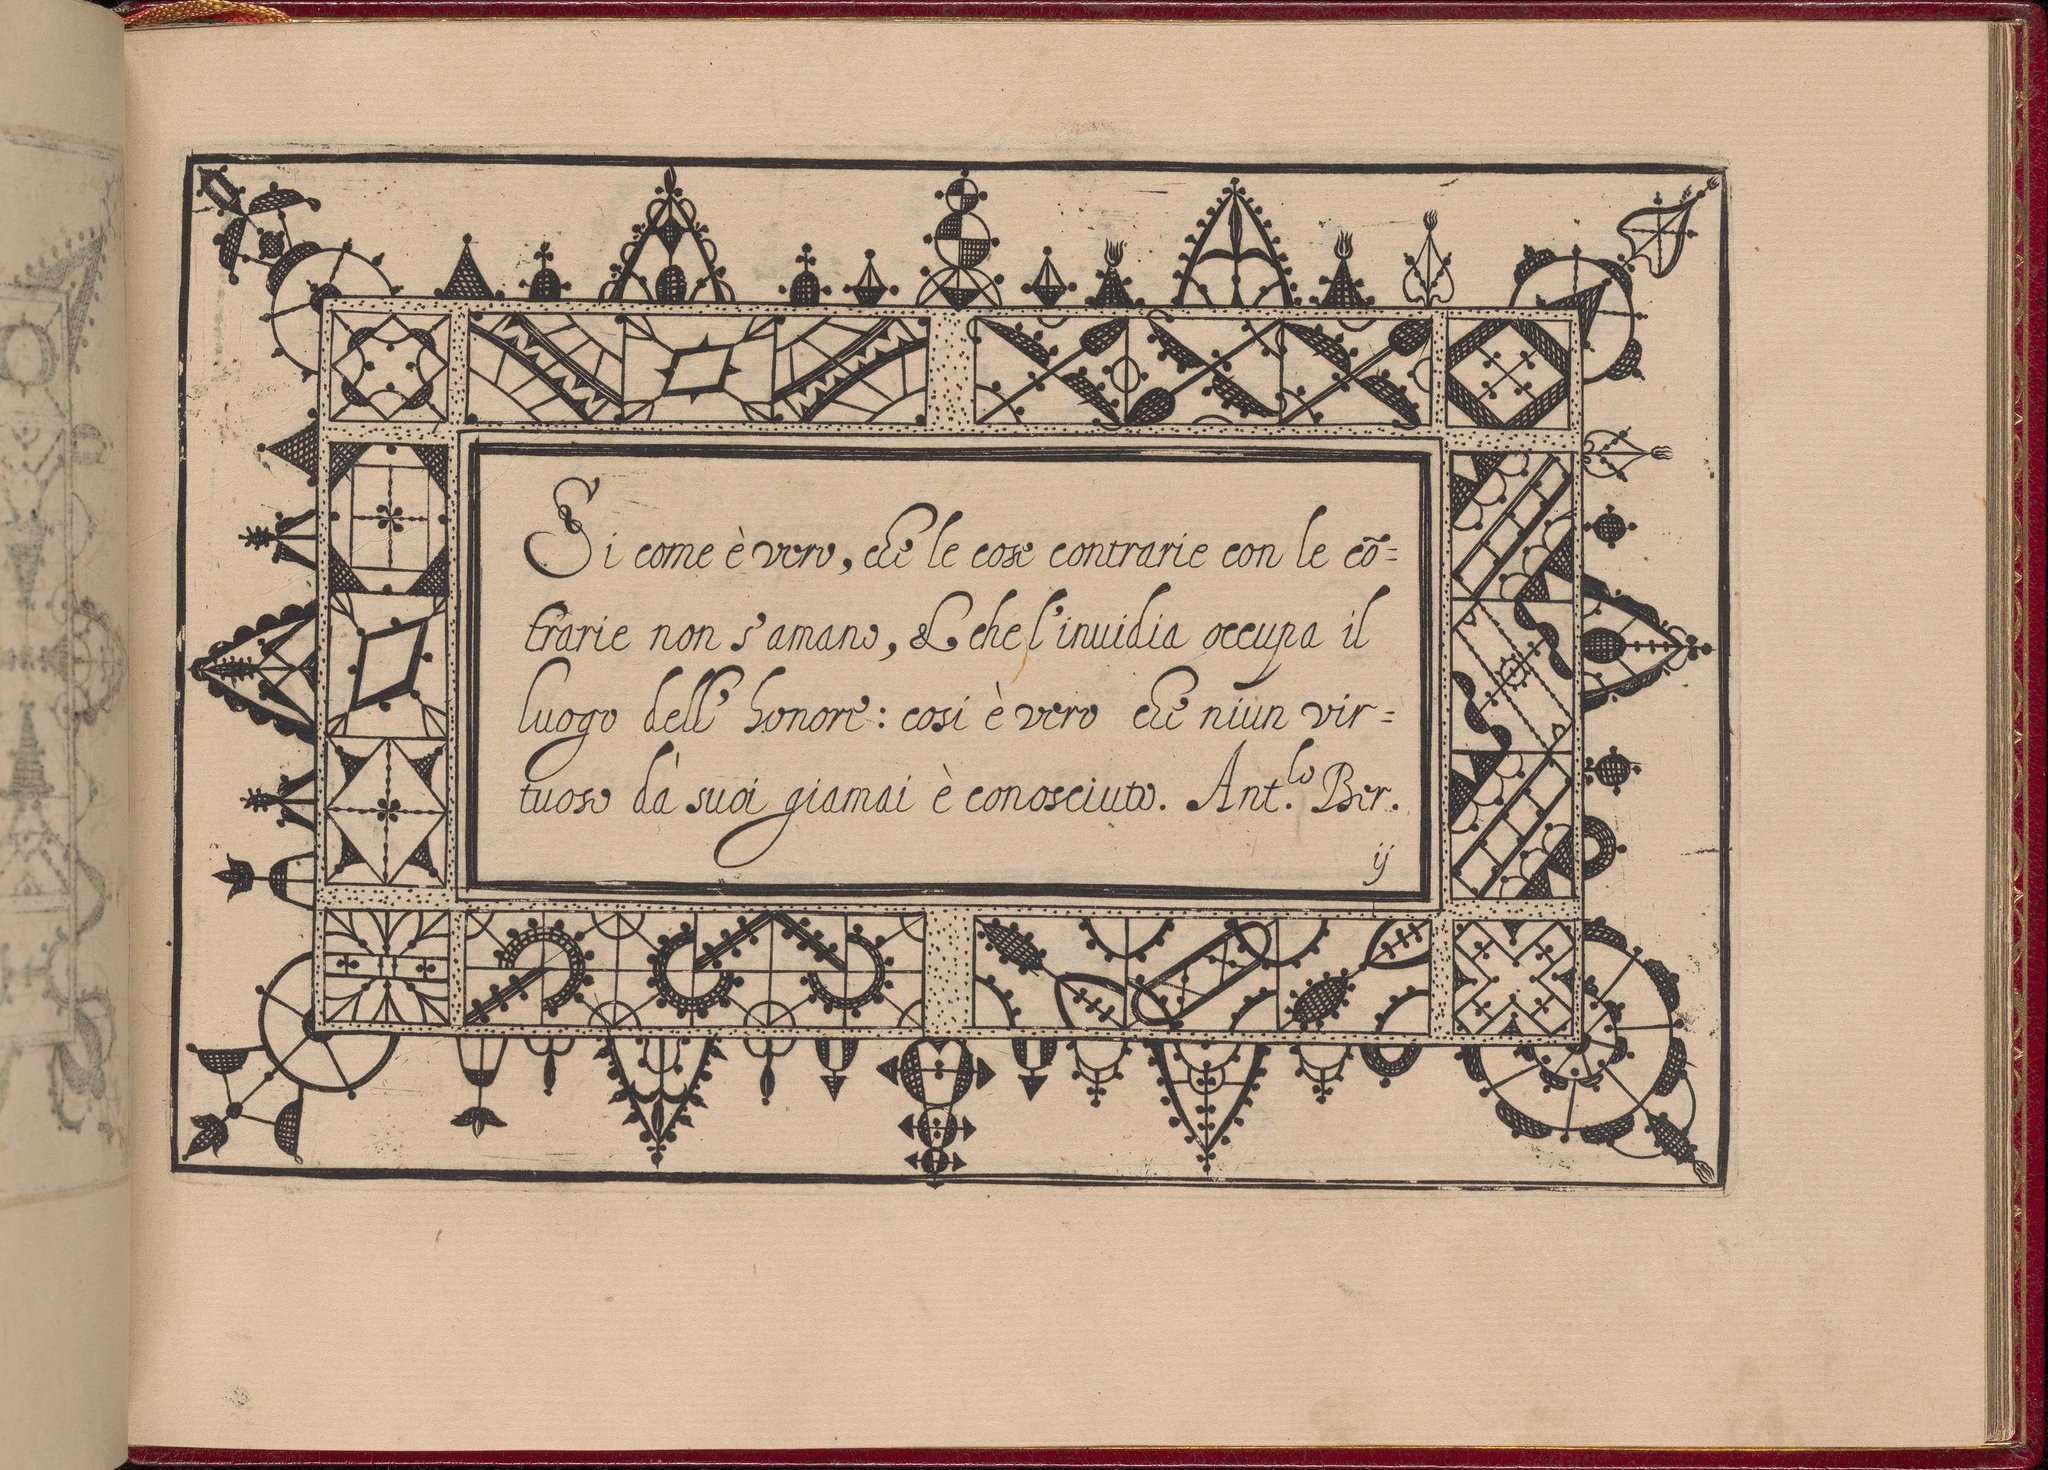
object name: book print ornament architecture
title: Ghirlanda: Di sei vaghi fiori scielti da piu famosi Giardini d'Italia, page 19 (recto)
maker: pietro paulo tozzi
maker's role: designer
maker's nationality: italian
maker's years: 1593-1628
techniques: drawing, etching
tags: ornament